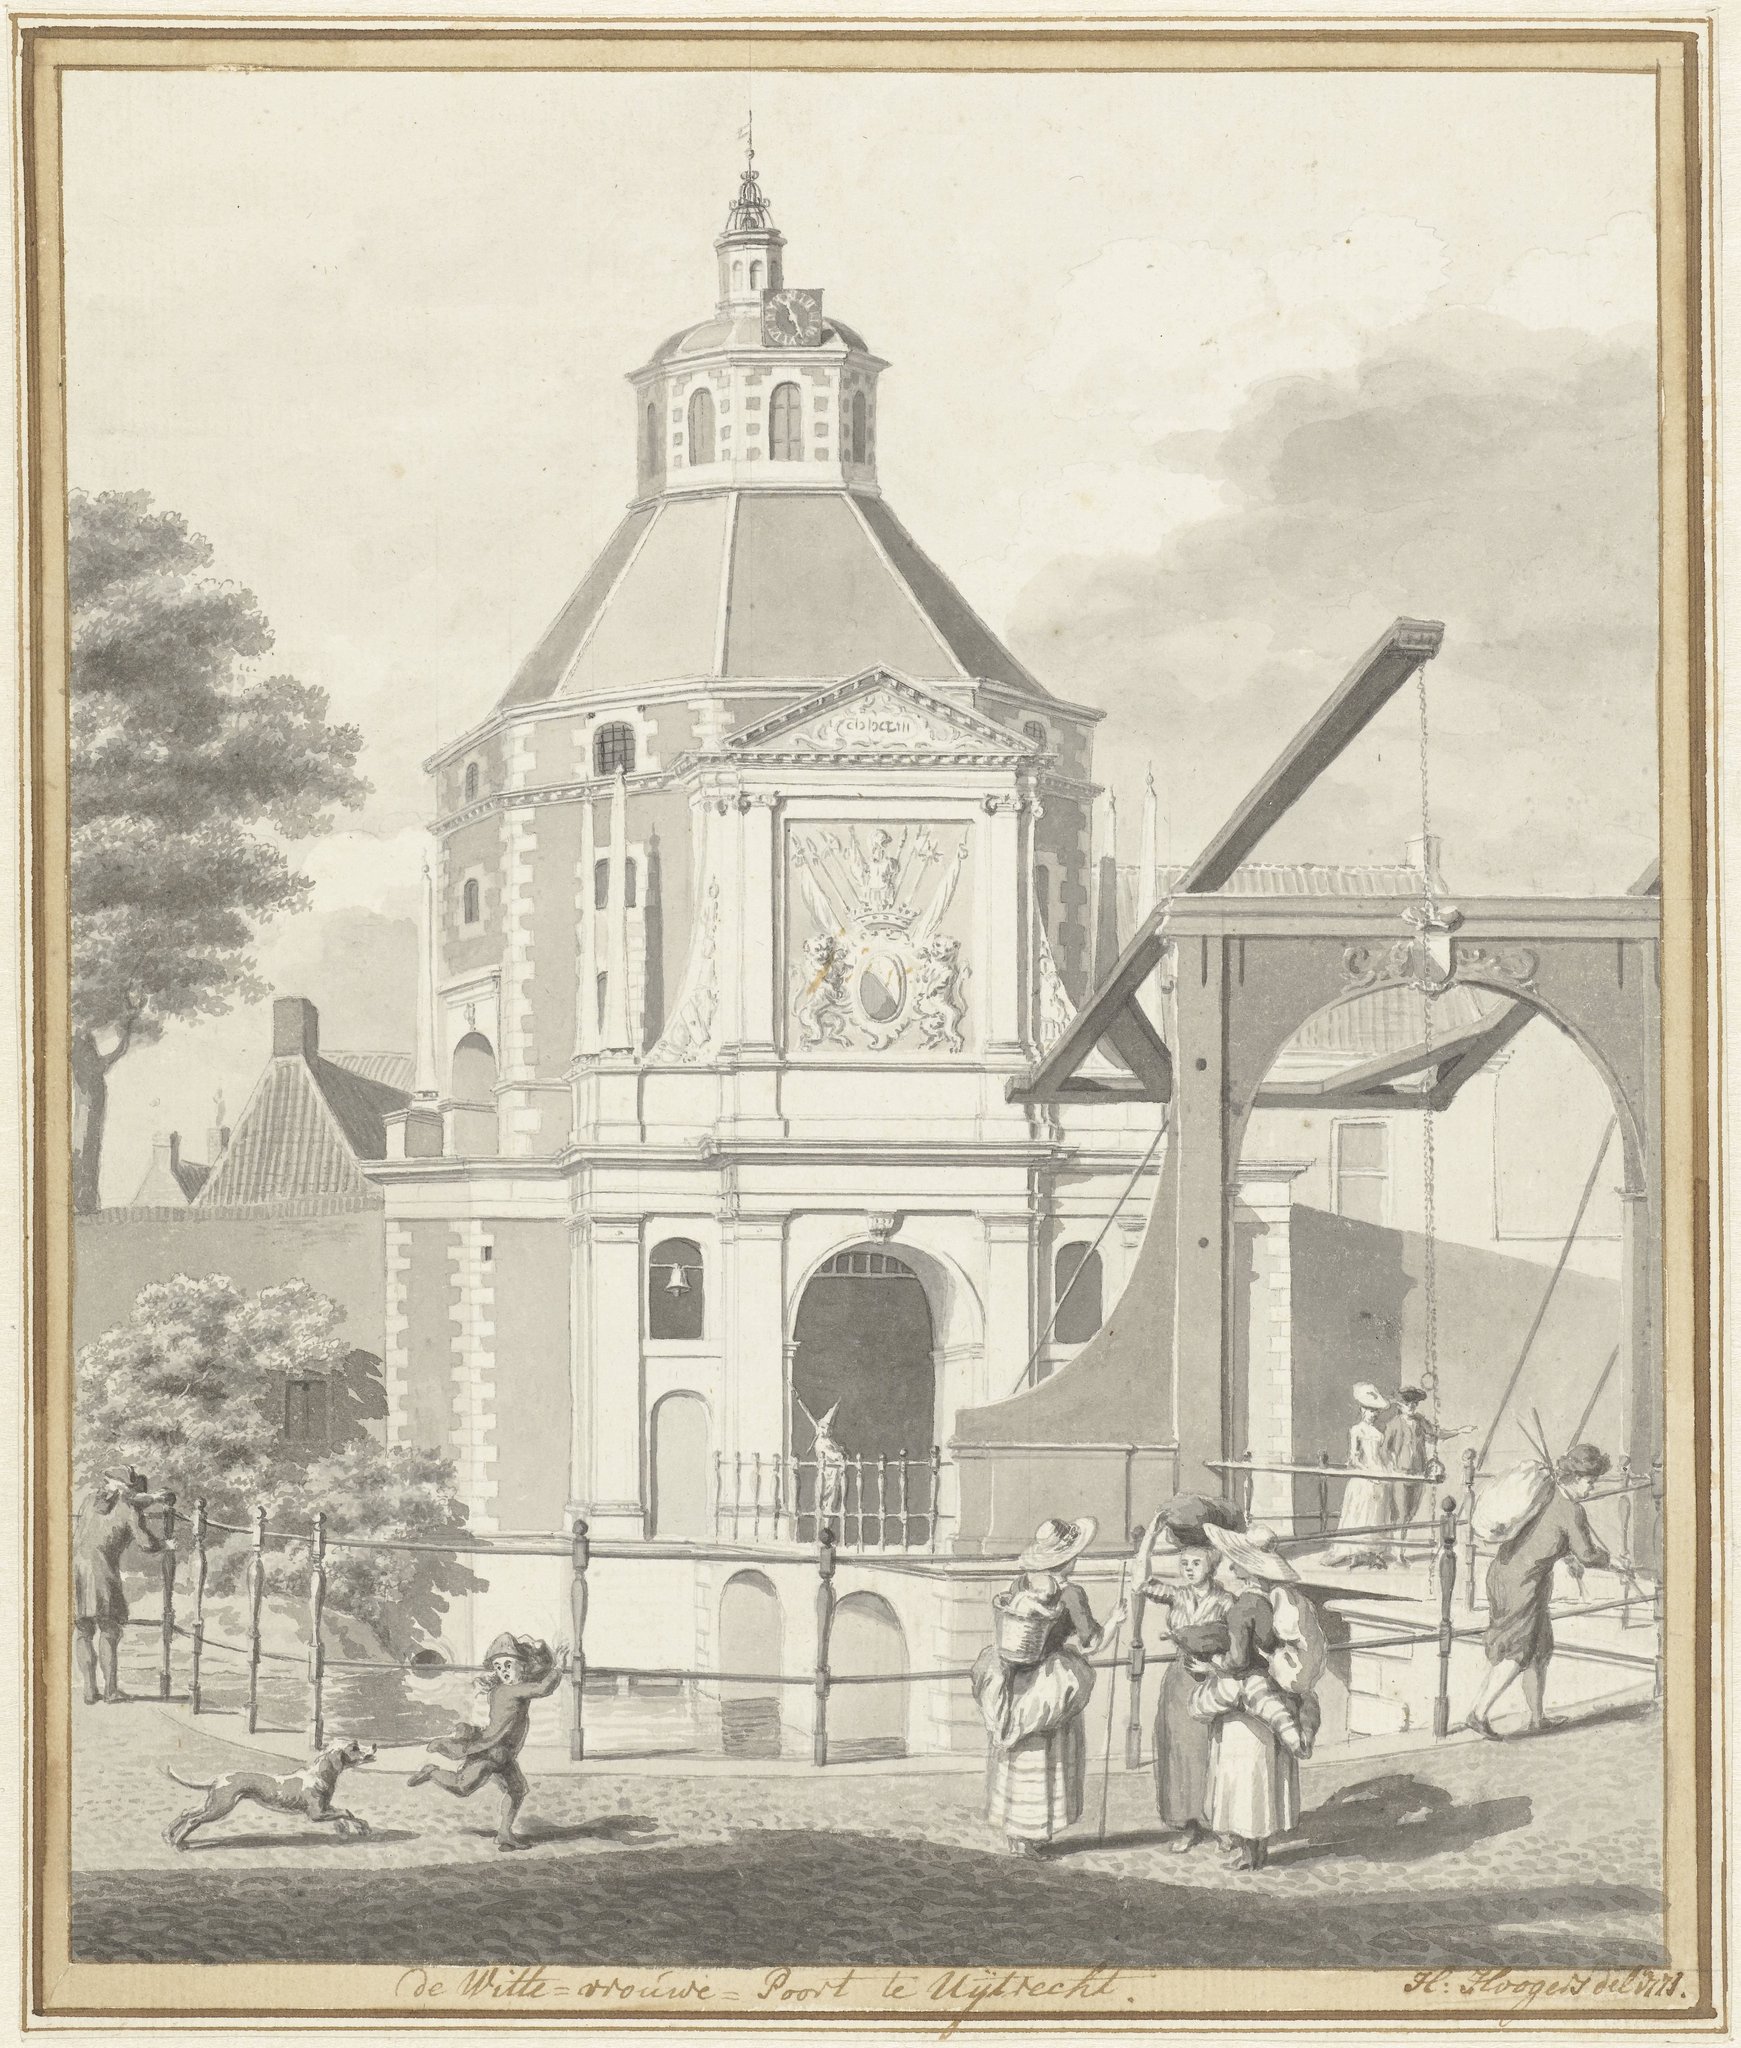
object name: drawing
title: De Wittevrouwen- of Gelderse Poort te Utrecht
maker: hendrik hoogers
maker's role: draughtsman, mayor, print maker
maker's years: 1747-1814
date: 1771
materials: ink, paper, pencil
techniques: brush, pen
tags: city-gate, utrecht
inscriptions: date: ‘1771’